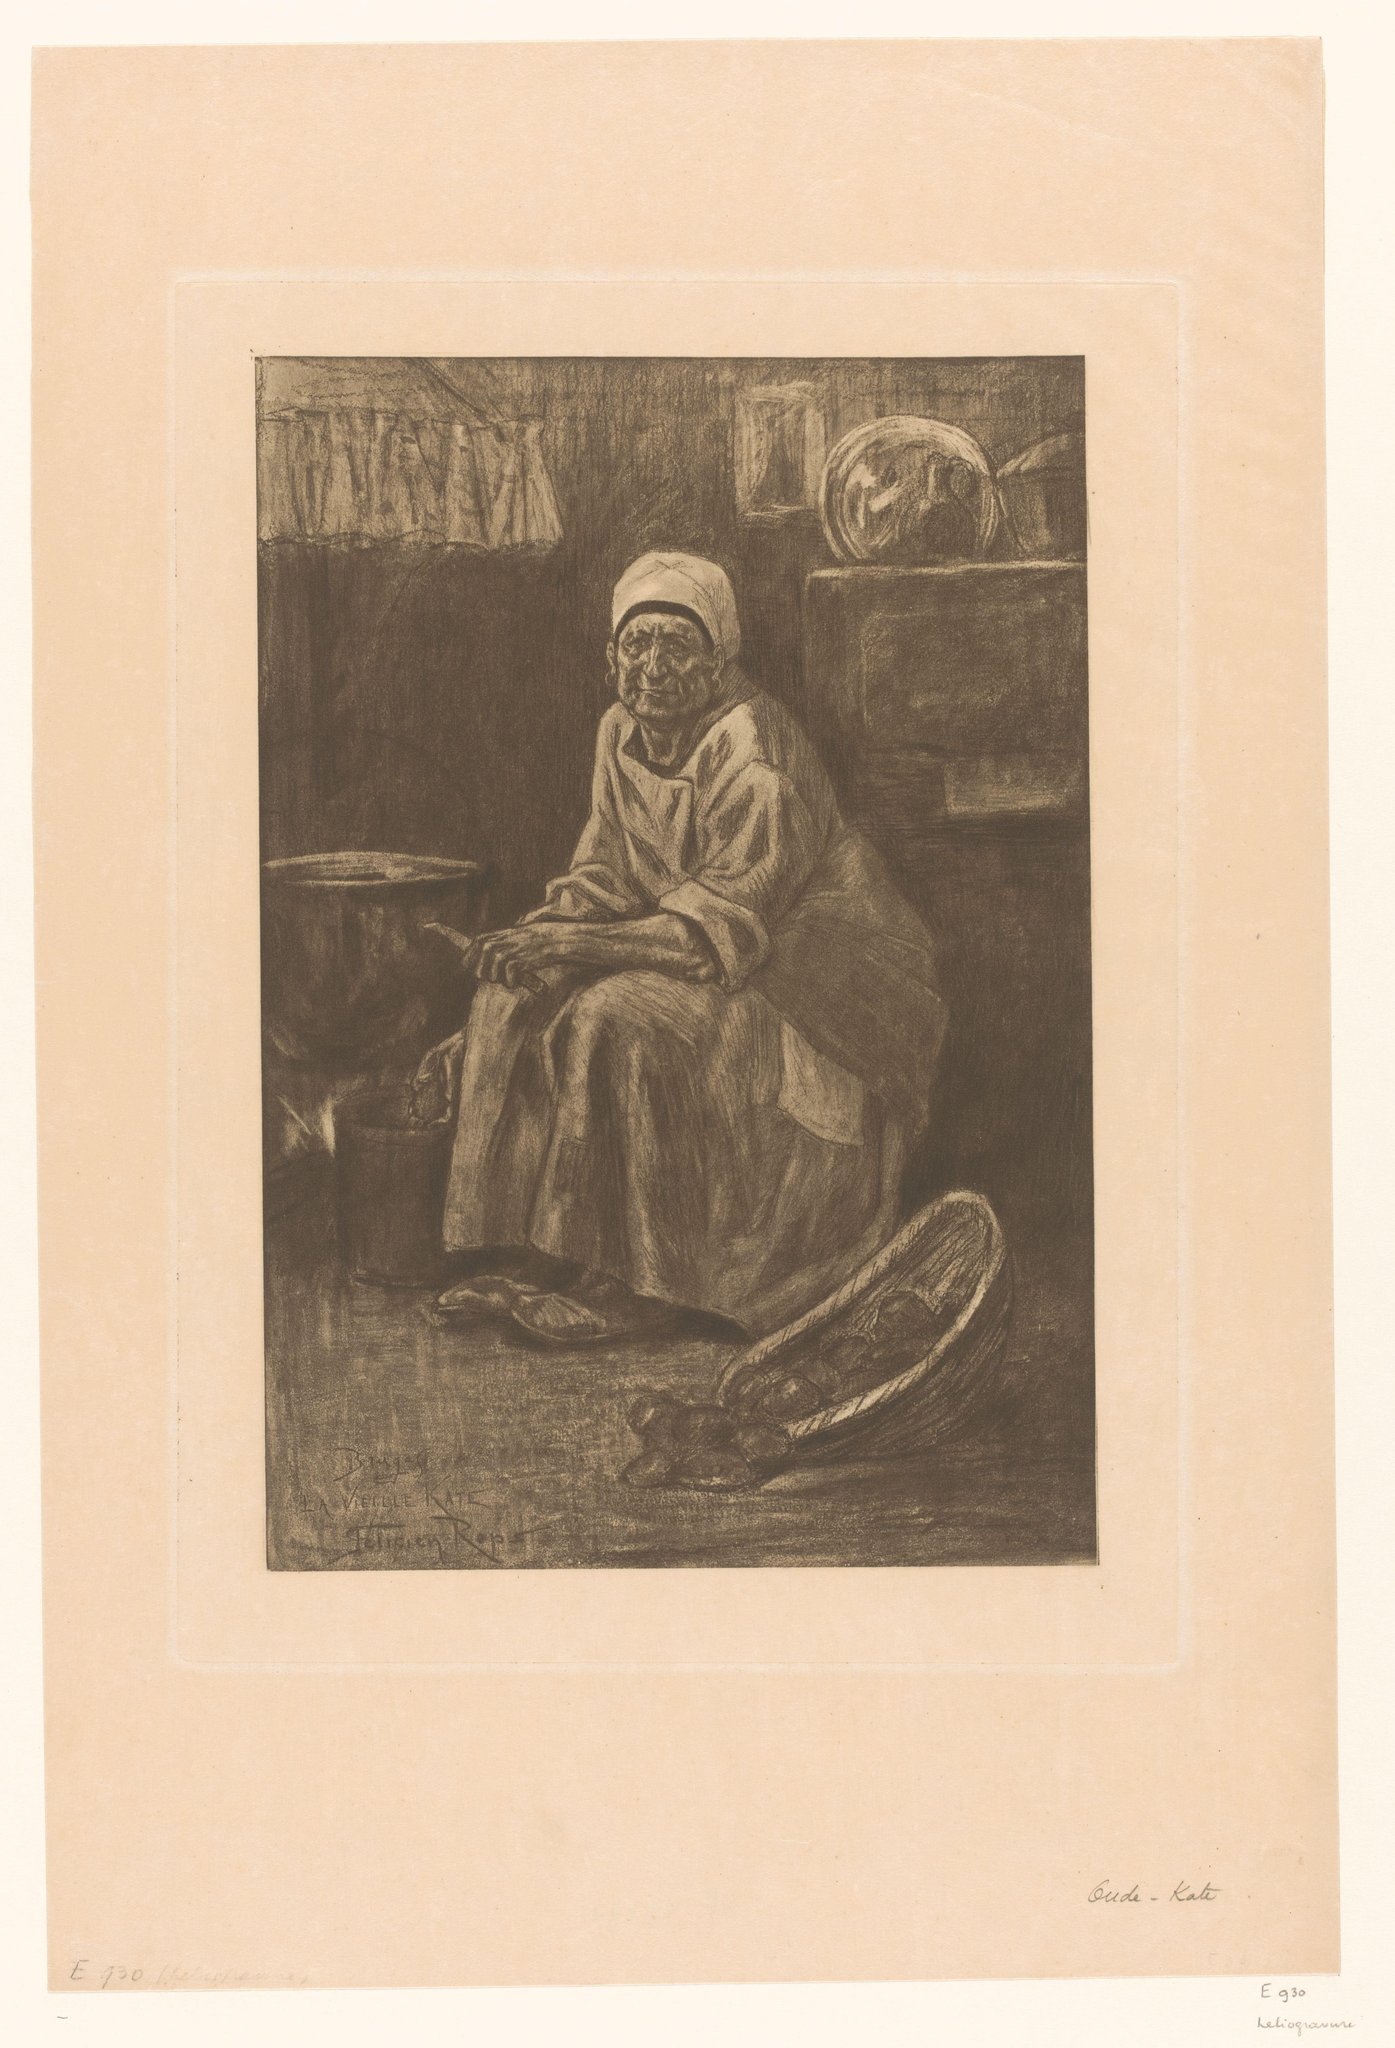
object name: photomechanical print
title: La vieille Kate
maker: félicien rops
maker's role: draughtsman, print maker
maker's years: 1833-1898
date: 1843-1898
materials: paper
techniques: photoaquatint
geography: bruges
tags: old woman, kitchen-interior, potatoes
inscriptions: collector's mark: Lugt 2228